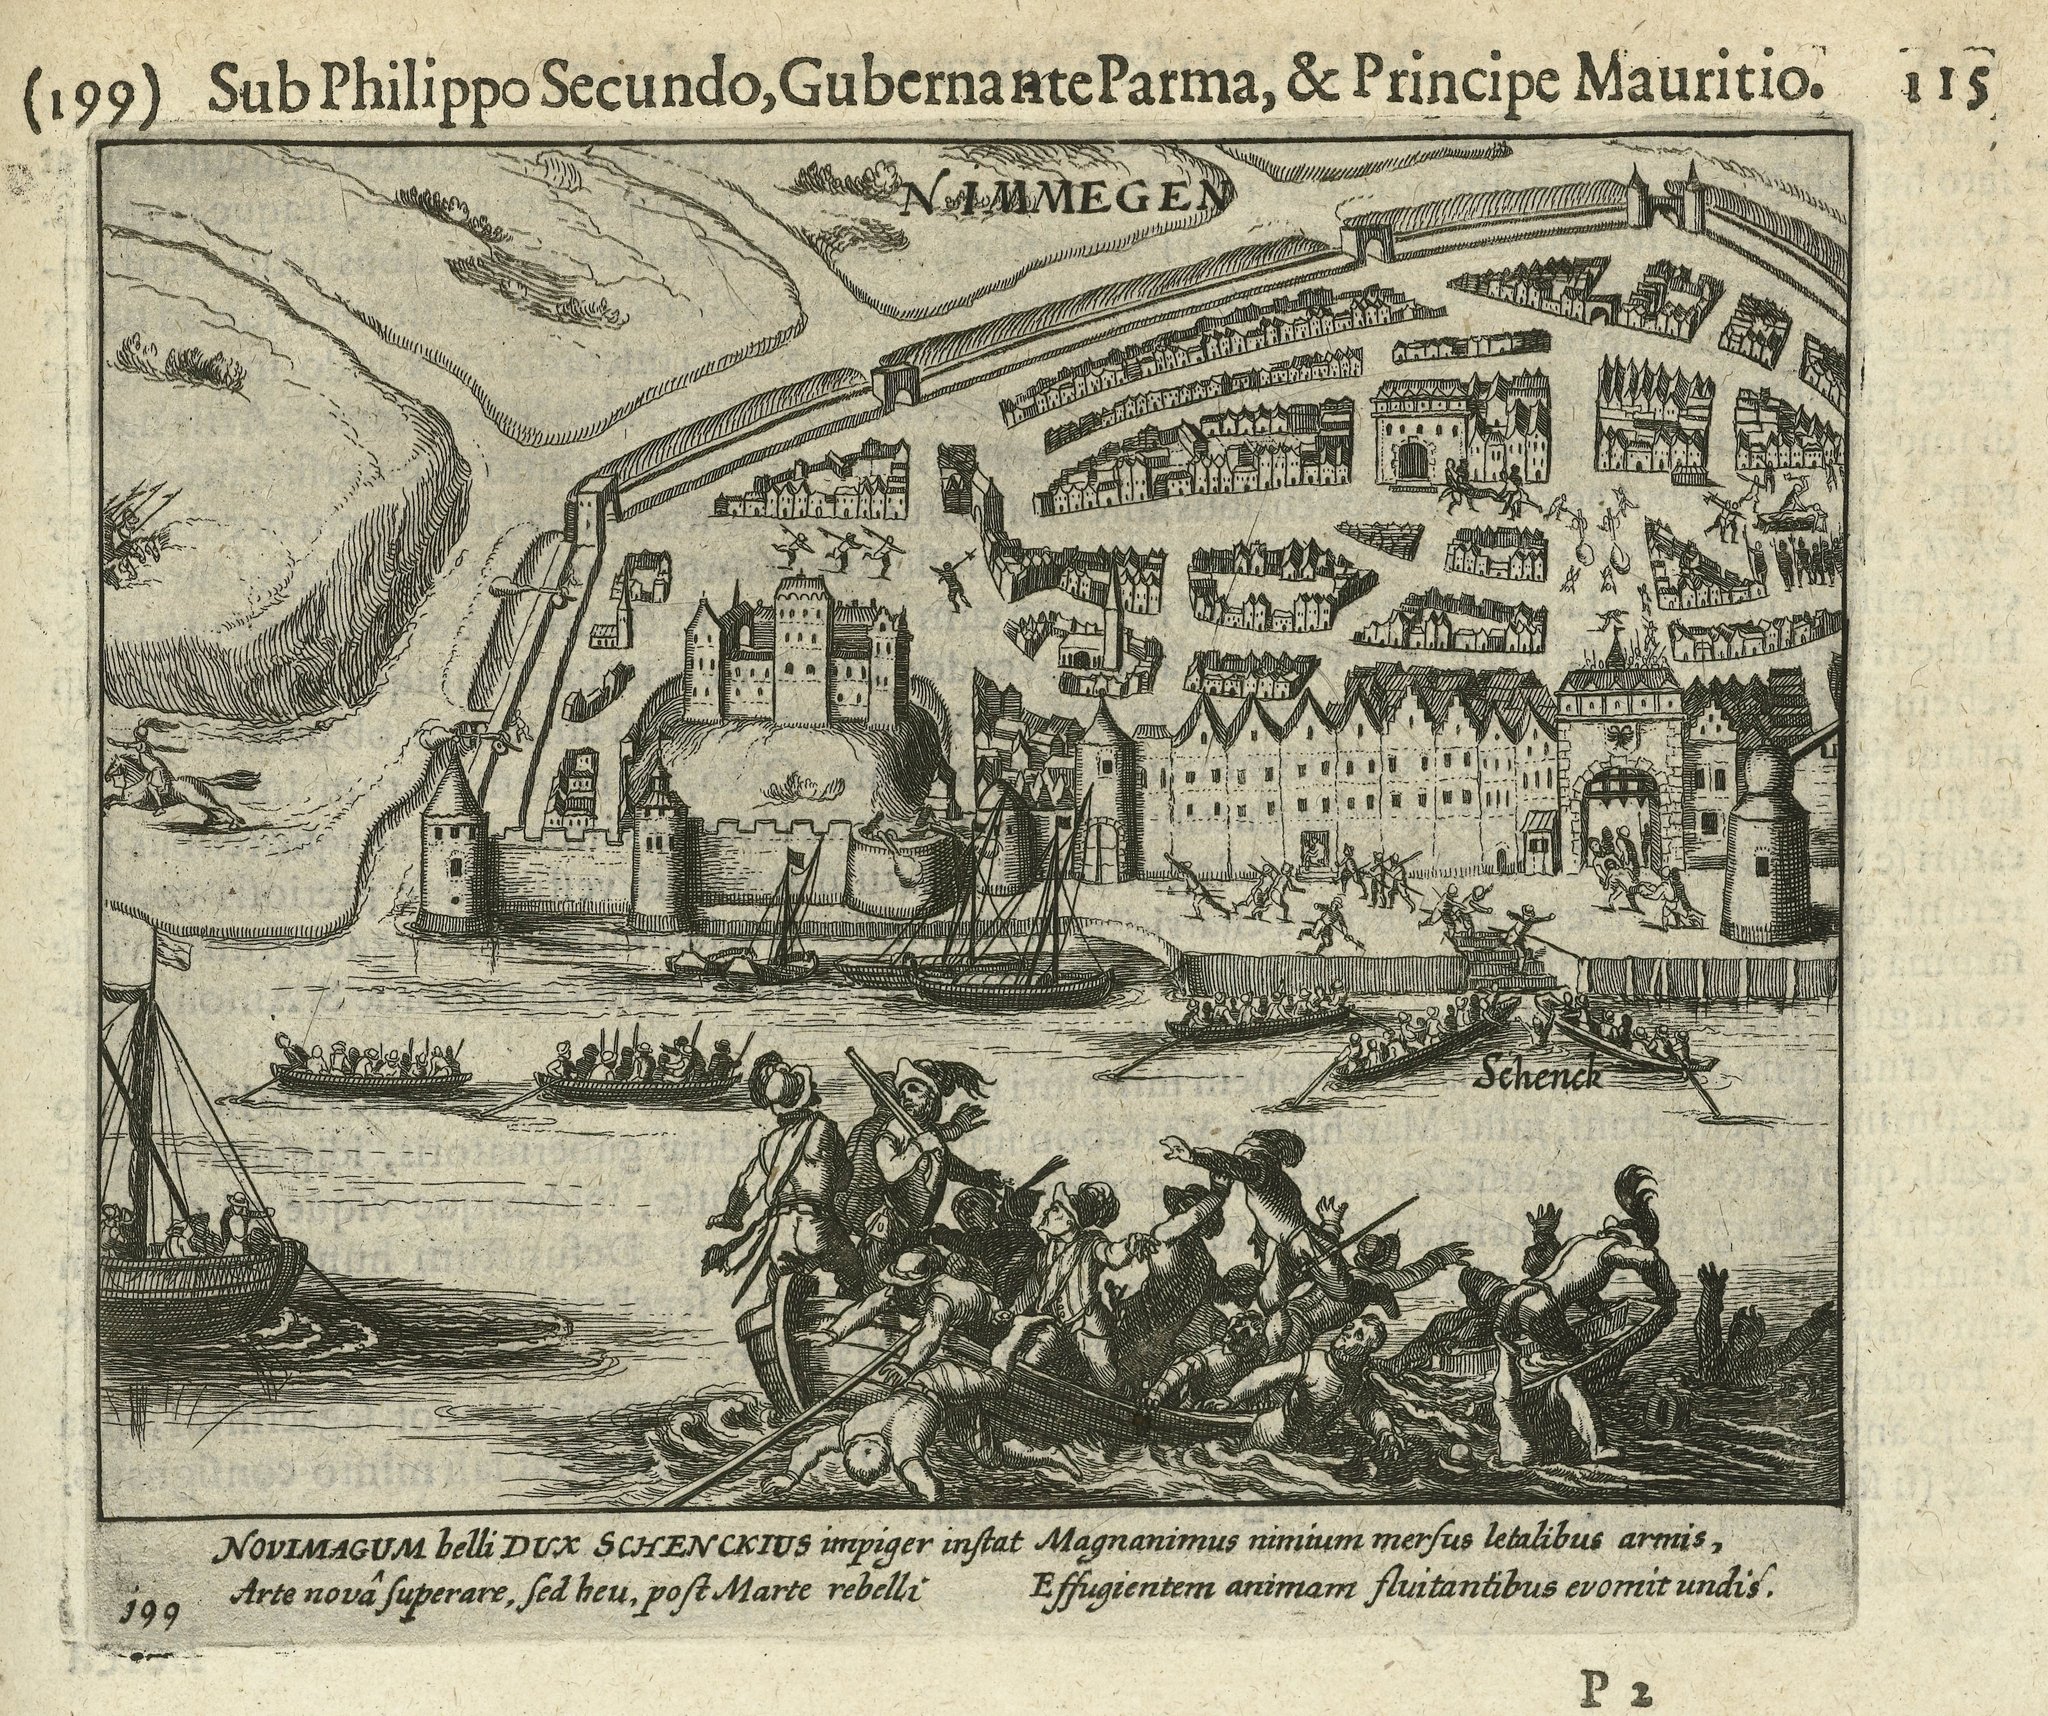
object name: print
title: Mislukte aanval op Nijmegen, 1589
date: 1613-1615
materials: paper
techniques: etching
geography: amsterdam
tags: nijmegen, drowning, shipwrecked person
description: Mislukte aanval op Nijmegen, 10 augustus 1589. Martin Schenck verdrinkt in de Waal. Episode uit de Keulse Oorlog. Met onderschrift van 4 regels in het Latijn. Genummerd 199. Bedrukt op achterzijde met tekst in het Latijn.